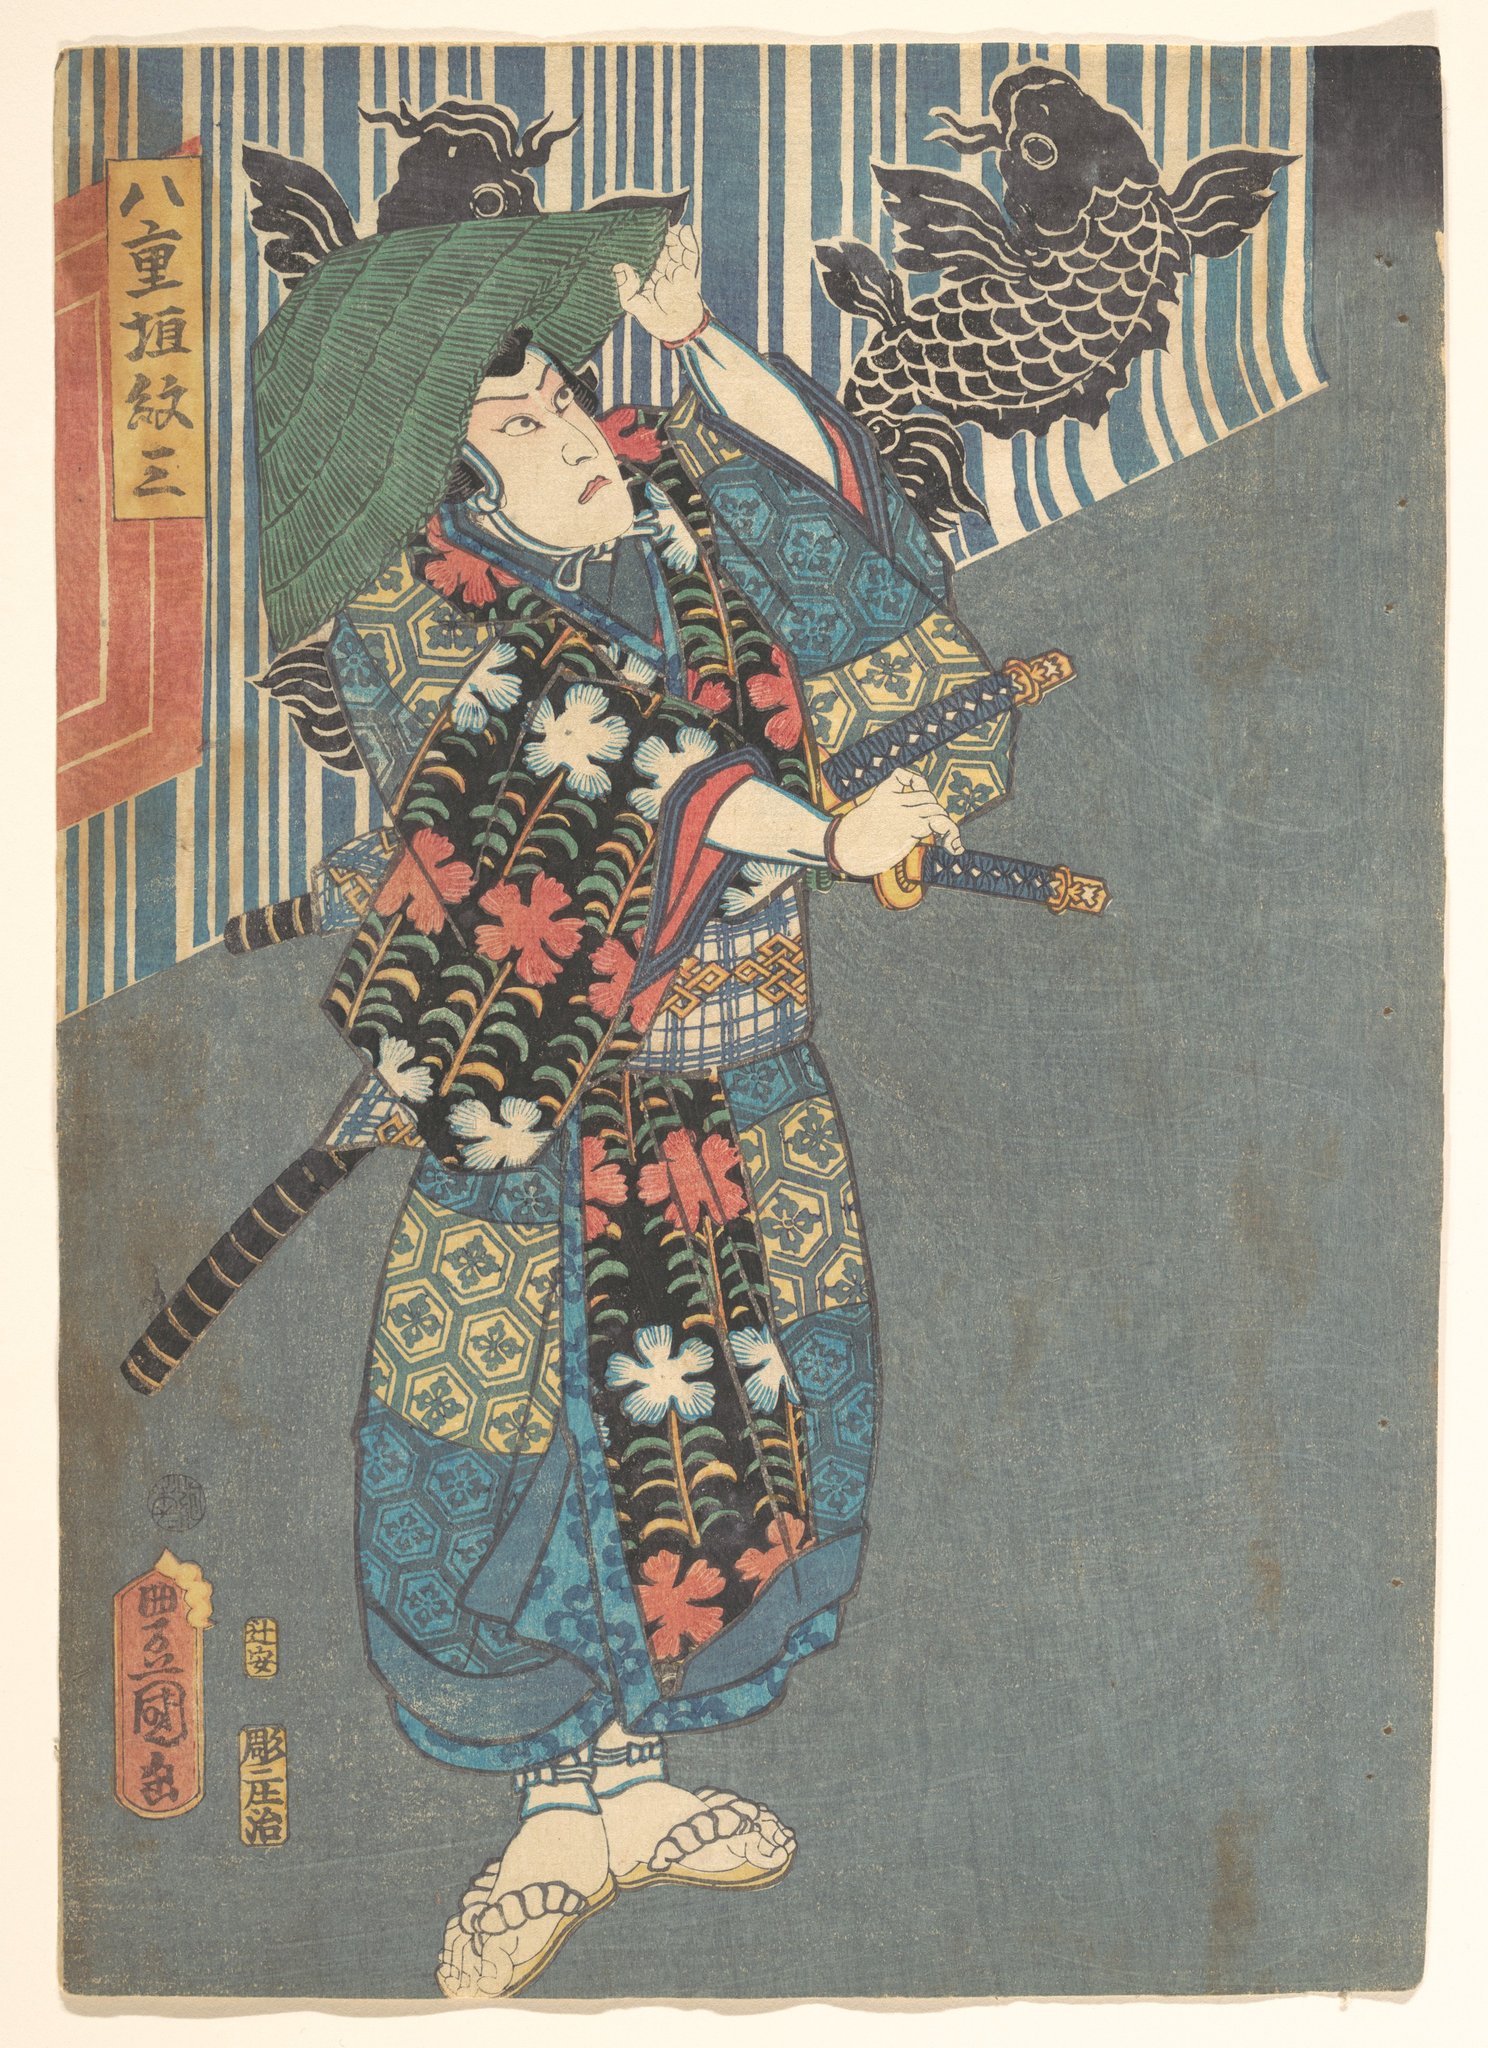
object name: print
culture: japanese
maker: utagawa kunisada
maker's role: artist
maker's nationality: japanese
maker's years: 1786-1864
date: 1801-1900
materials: ink, paper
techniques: woodblock print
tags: hats,swords,men,mythical creatures